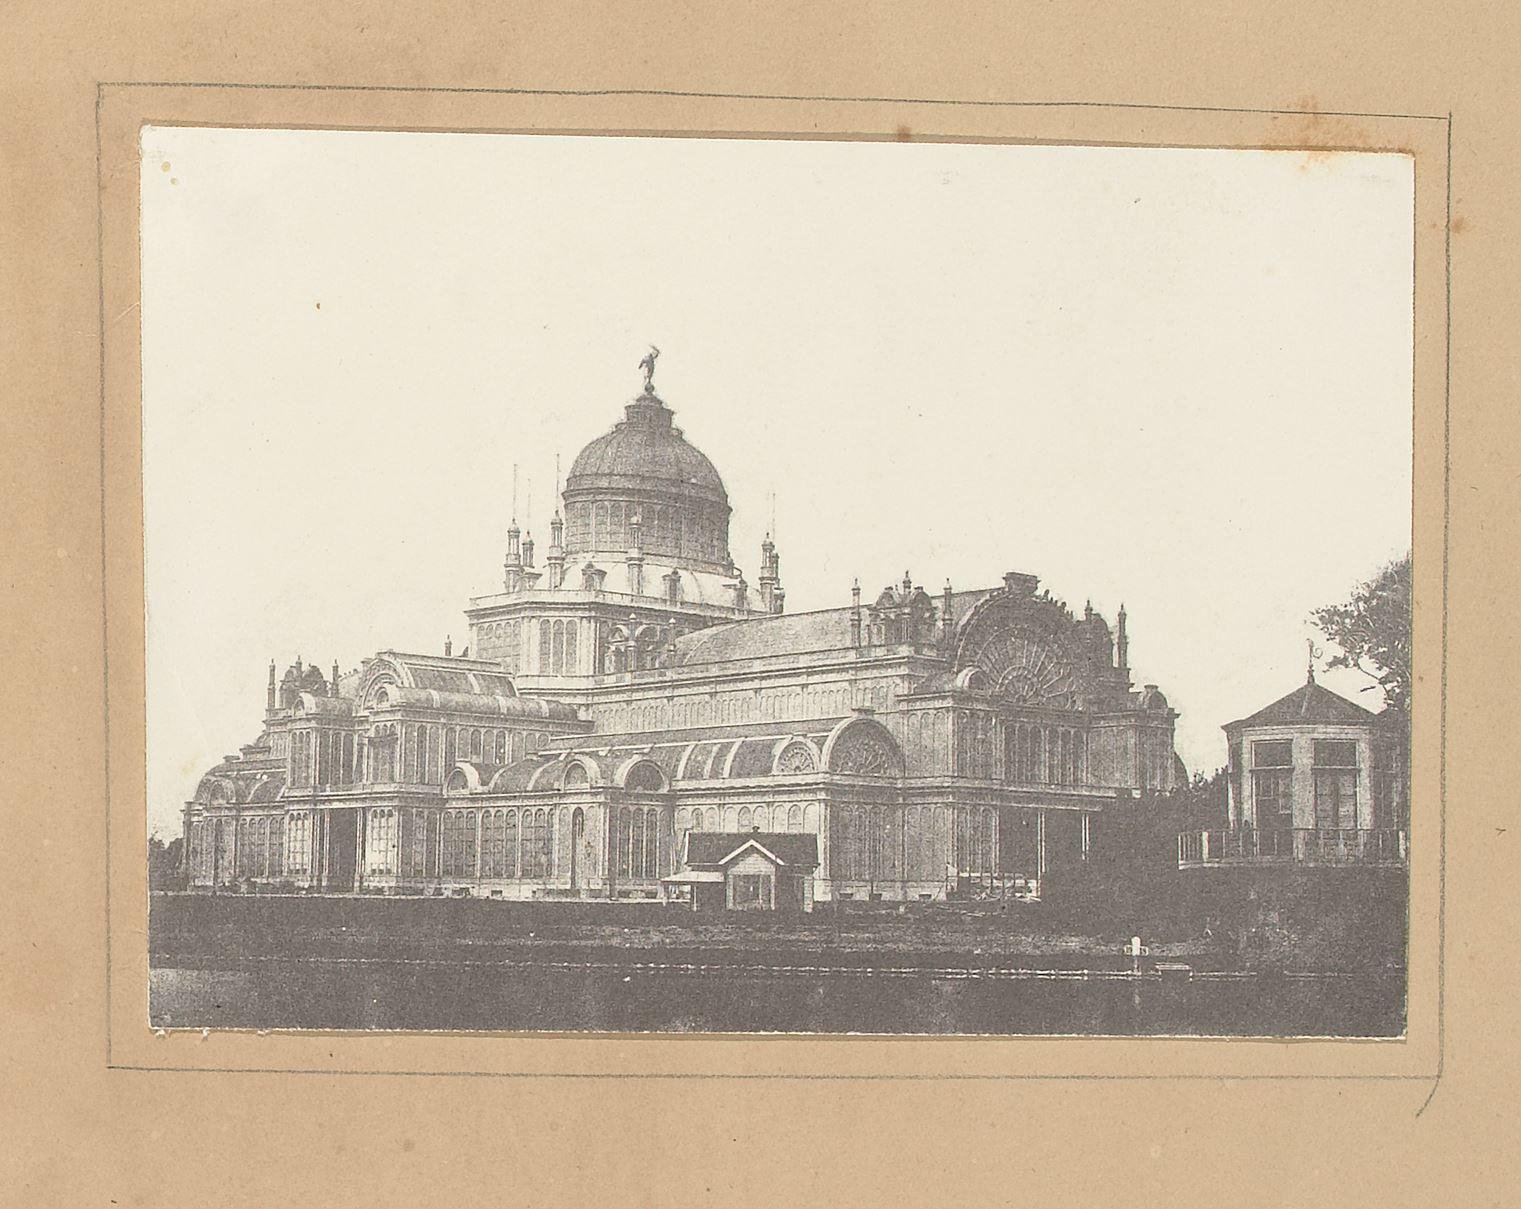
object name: photograph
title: Het Paleis voor Volksvlijt in Amsterdam vlak na de opening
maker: eduard isaac asser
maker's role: amateurfotograaf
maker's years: 1809-1894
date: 1865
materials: cardboard, paper, photographic support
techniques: photolithography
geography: amsterdam